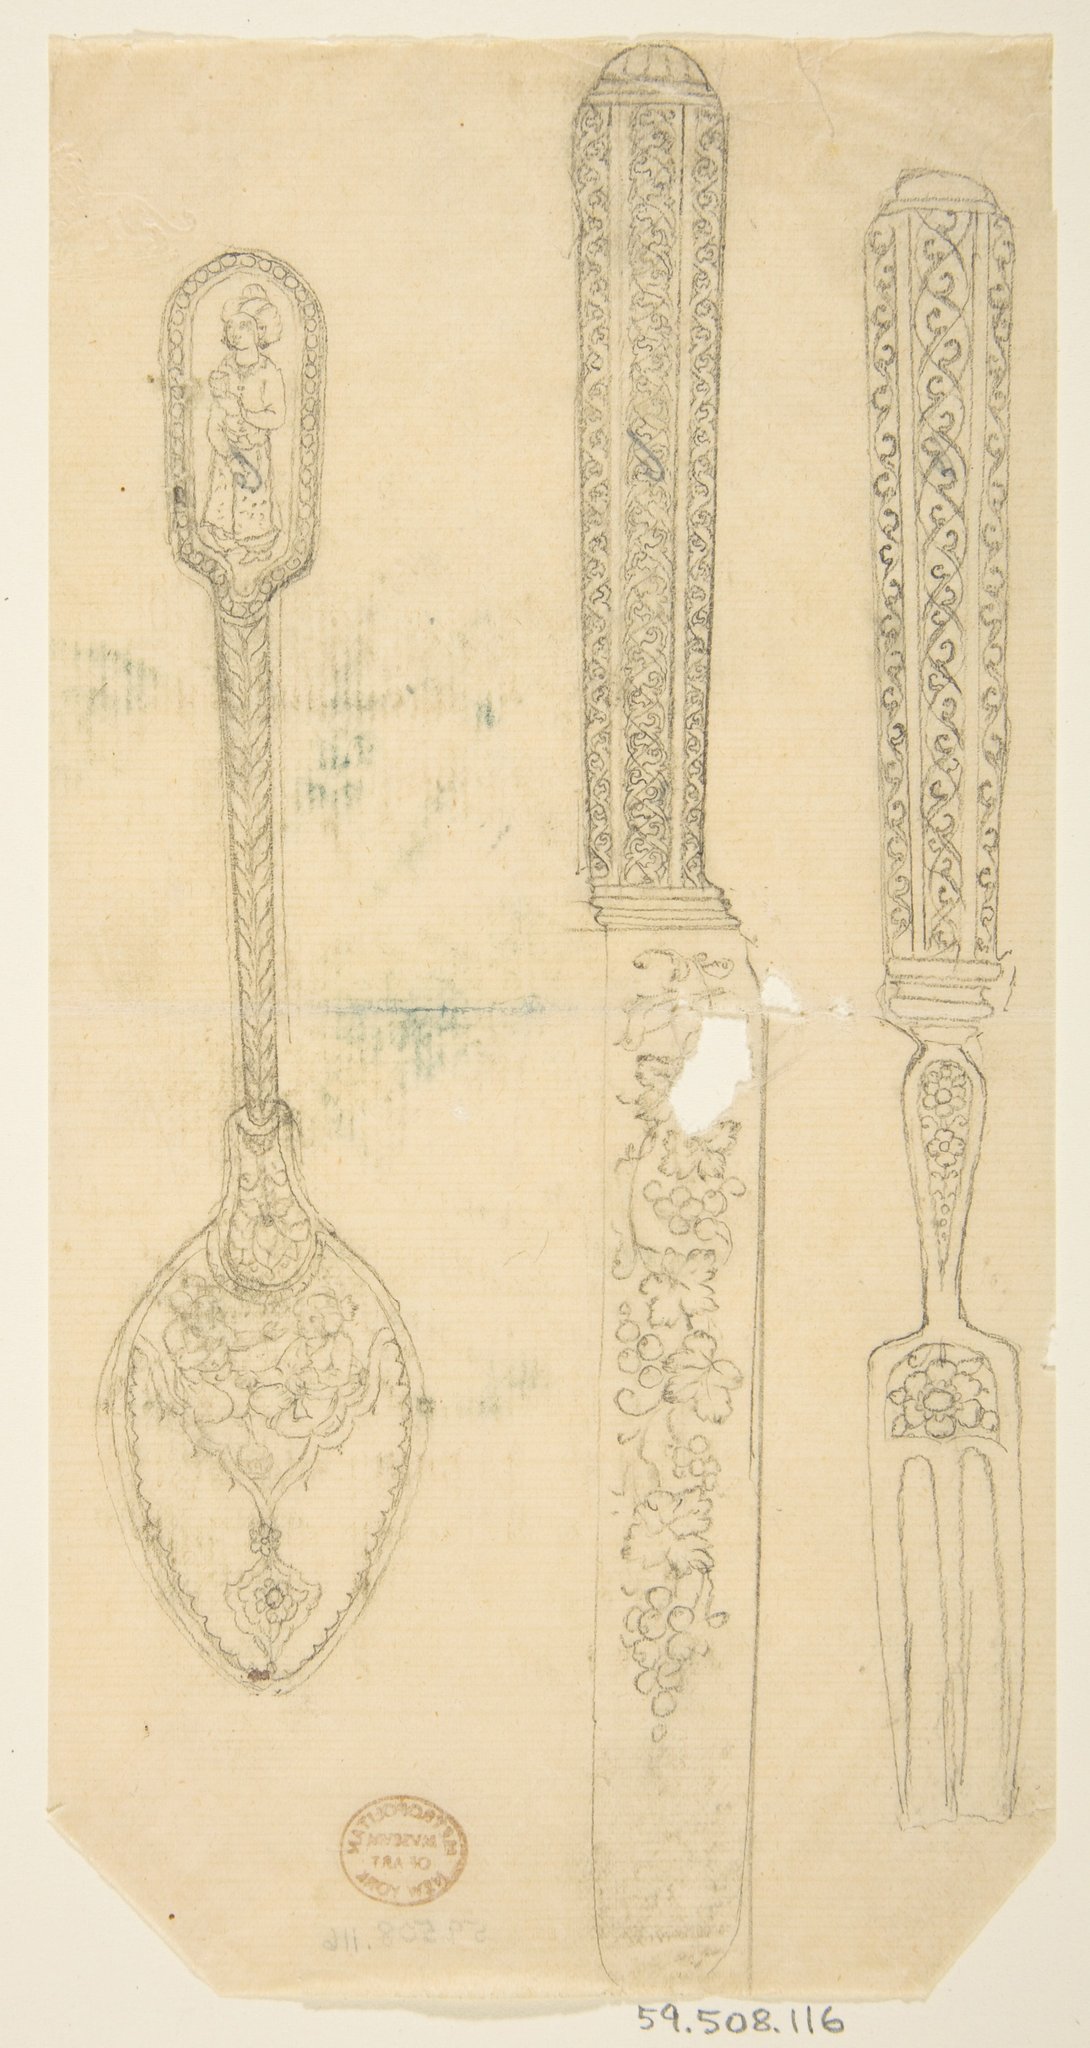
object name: drawing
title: Design for Silverware: Spoon, Knife, and Fork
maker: anonymous, french, 19th century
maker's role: artist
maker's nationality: french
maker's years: 1800-1900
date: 1801-1900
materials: graphite, paper